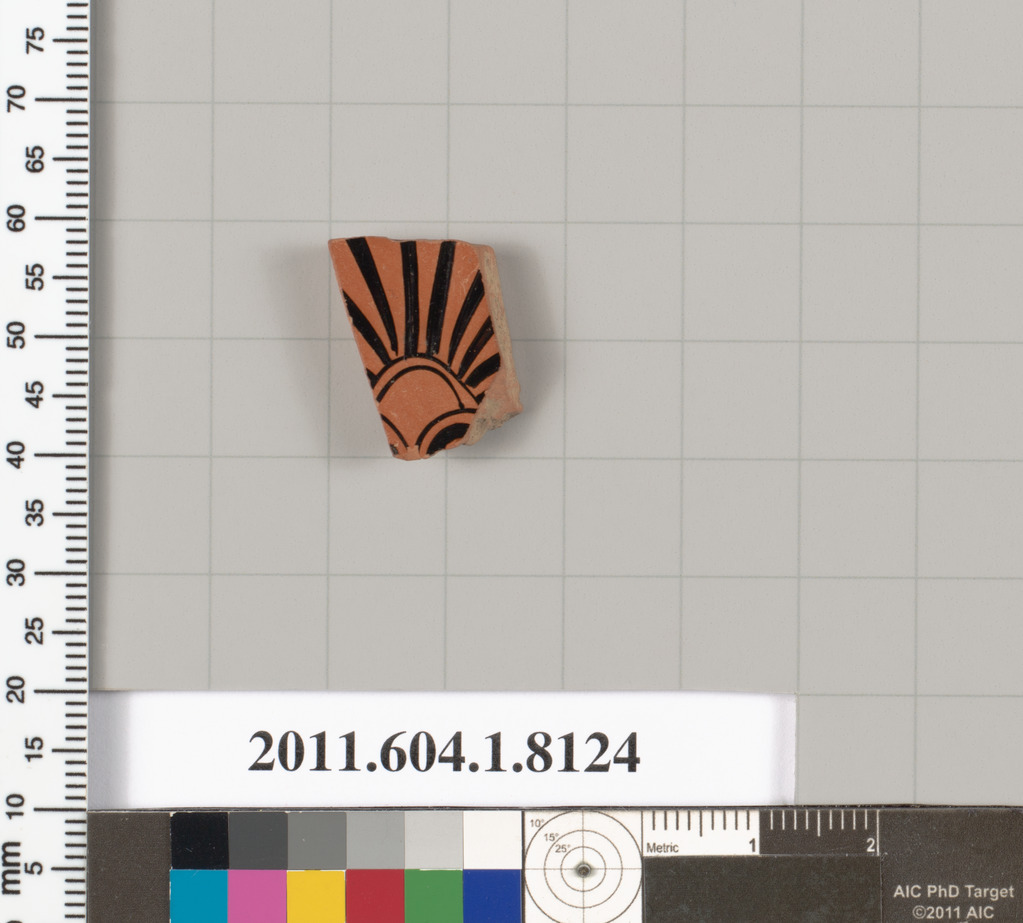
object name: kylix fragment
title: Terracotta fragment of a kylix (drinking cup)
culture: greek, attic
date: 534-468 BCE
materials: terracotta